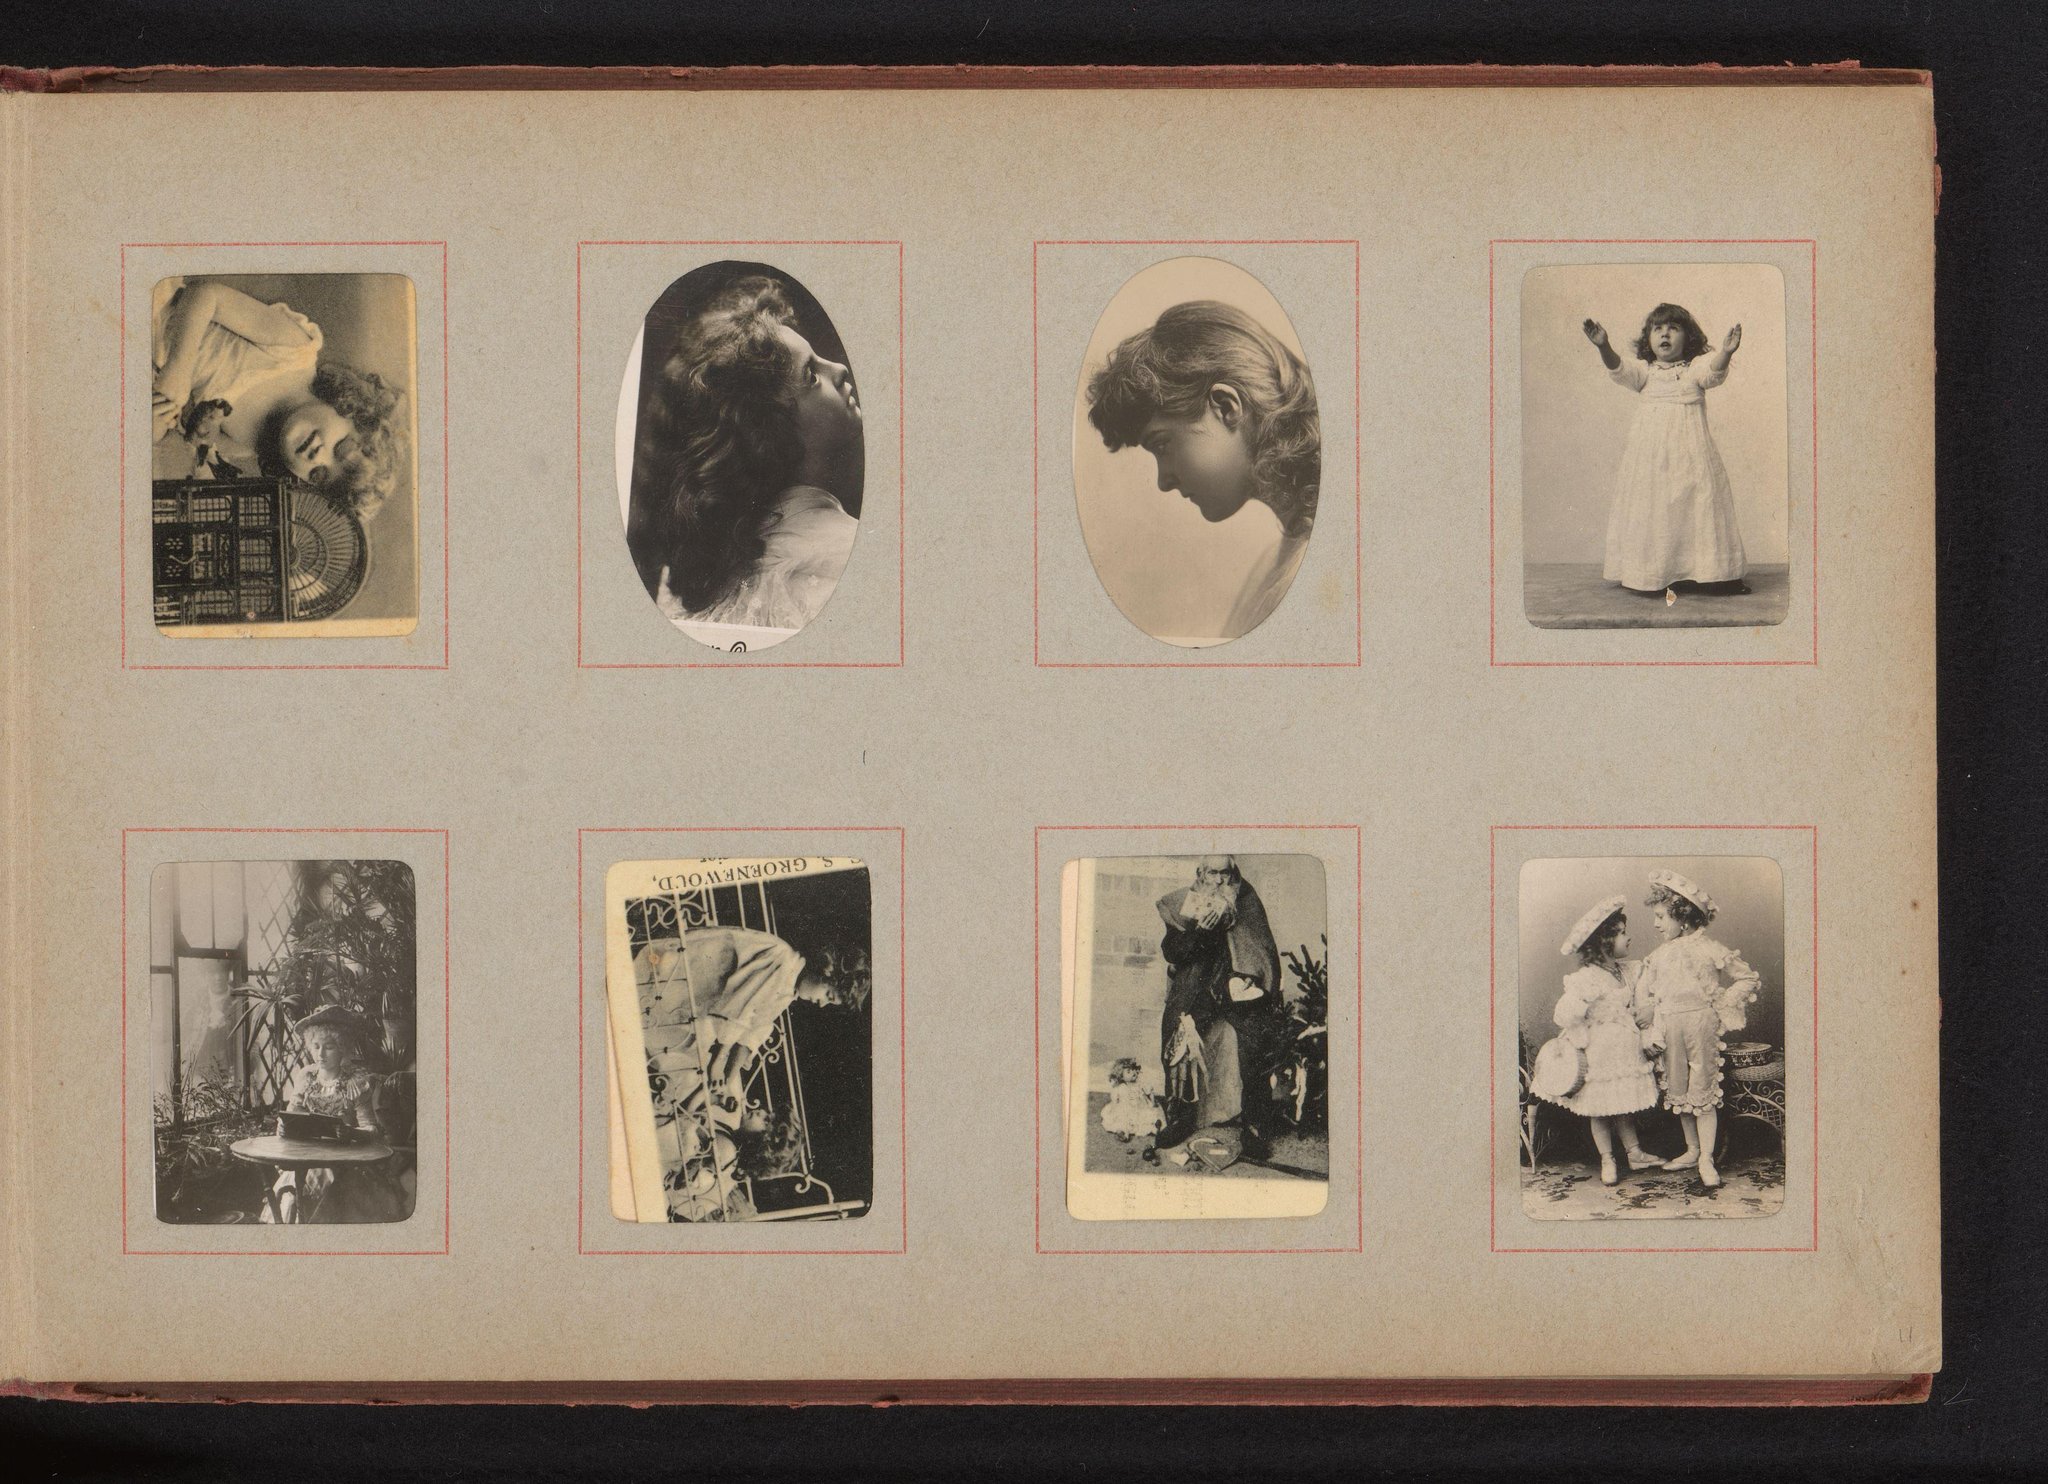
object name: photomechanical print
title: Kinderportretten en een portret van een oude man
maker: Anonymous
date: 1890-1900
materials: cardboard, paper, photographic support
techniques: photograph, gelatin silver print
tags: girl (child between toddler and youth), old man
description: Zeven portretten van kinderen, waaronder een portret van twee meisjes met een vogel en een meisje met een pop, en een portret van een oude man bij een kerstboom. Deze pagina maakt deel uit van een album.